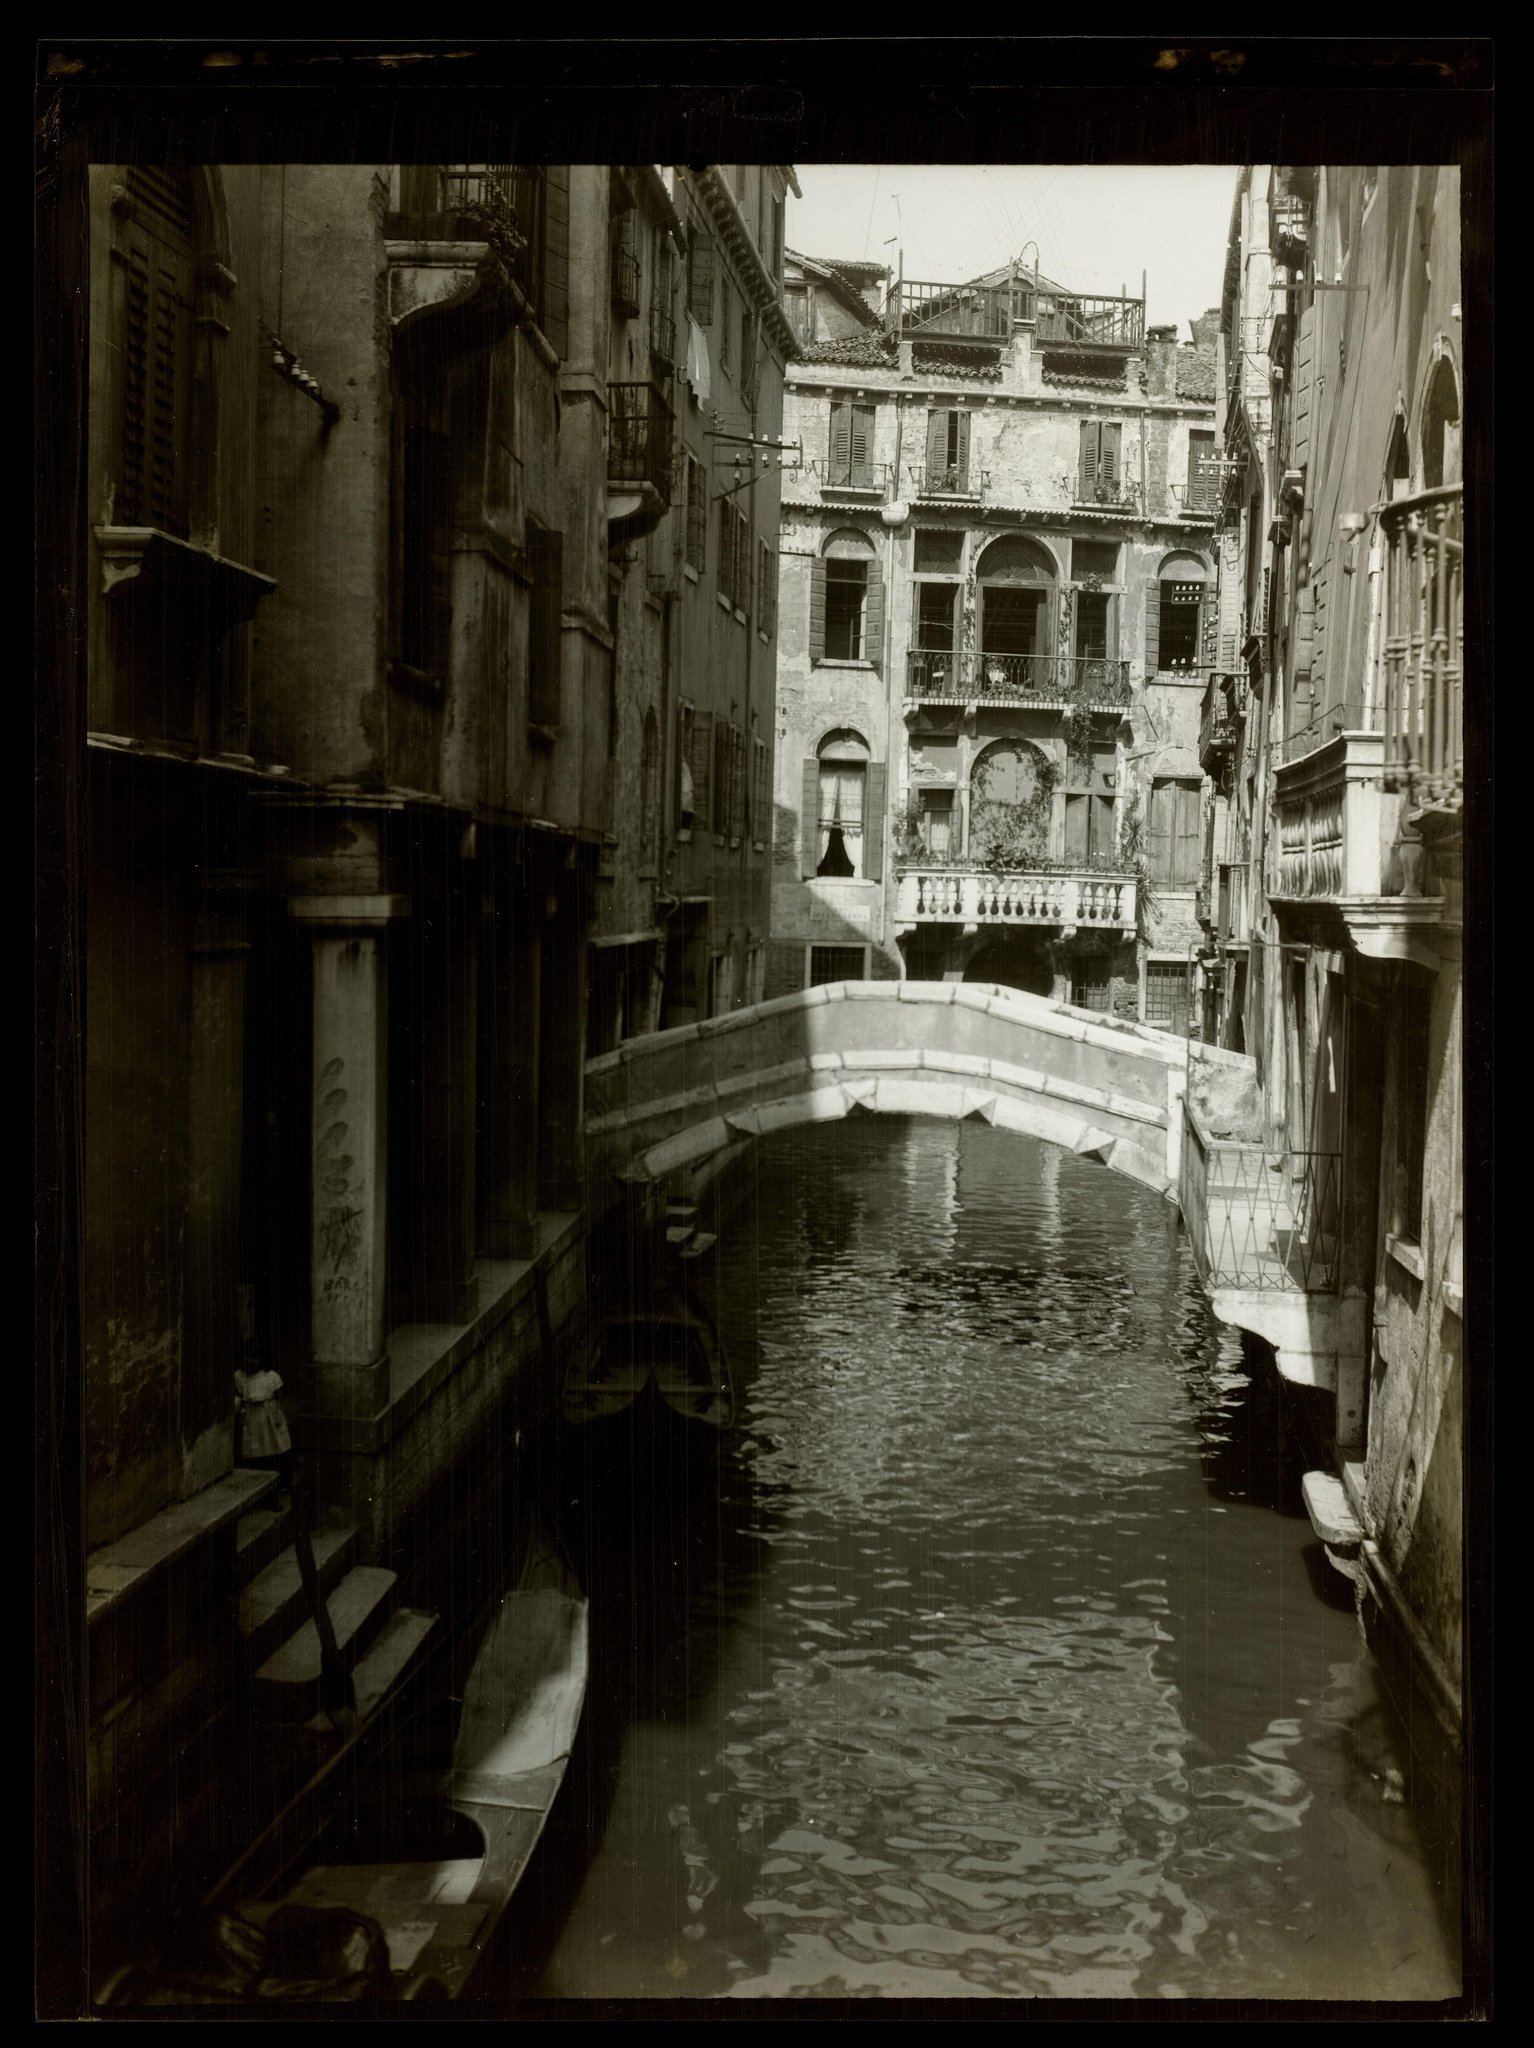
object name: photograph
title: Filmnegatief met opname van Venetië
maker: Anonymous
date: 1907-1935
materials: film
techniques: gelatin silver negative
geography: venice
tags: venice